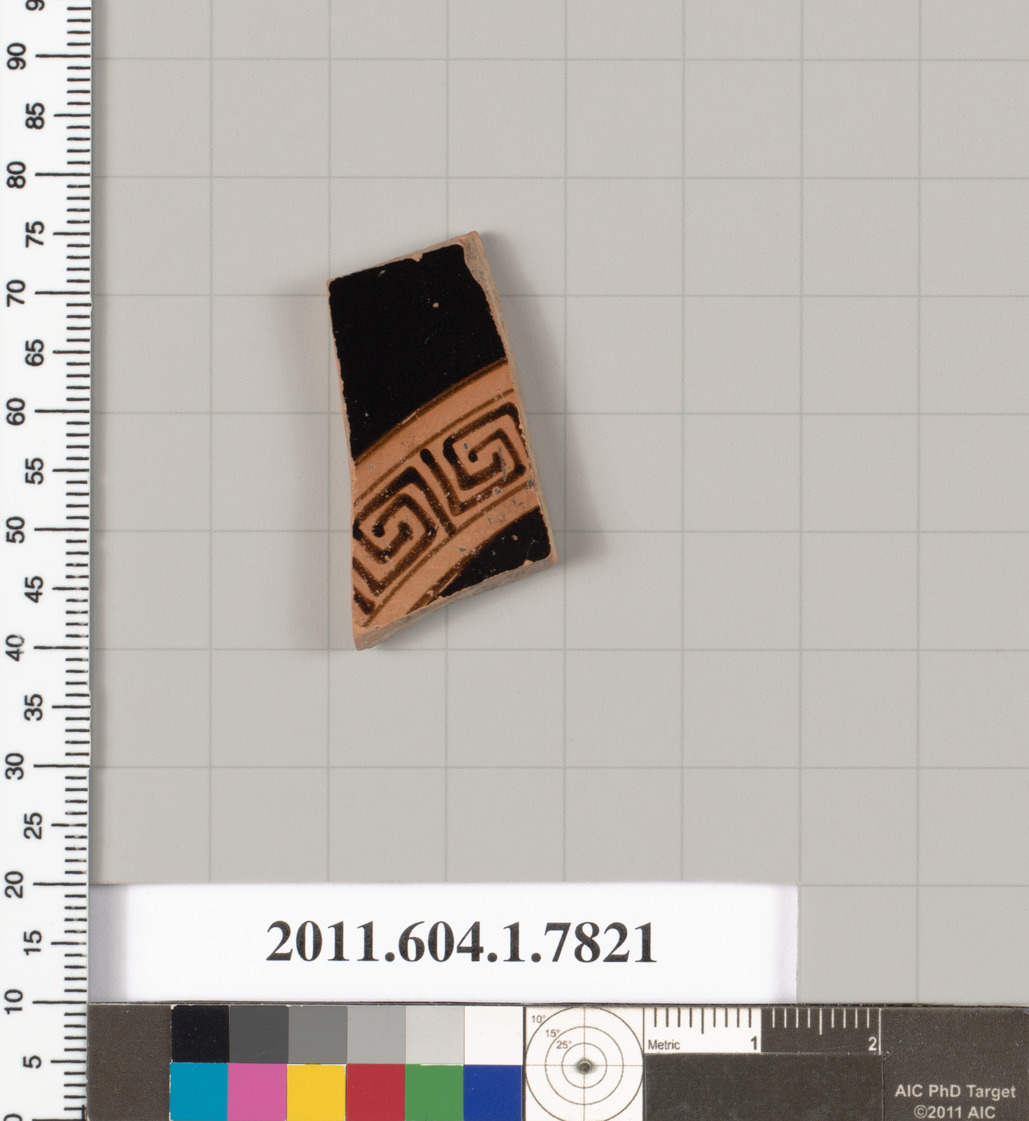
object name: kylix fragment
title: Terracotta fragment of a kylix (drinking cup)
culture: greek, attic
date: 460-450 BCE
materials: terracotta